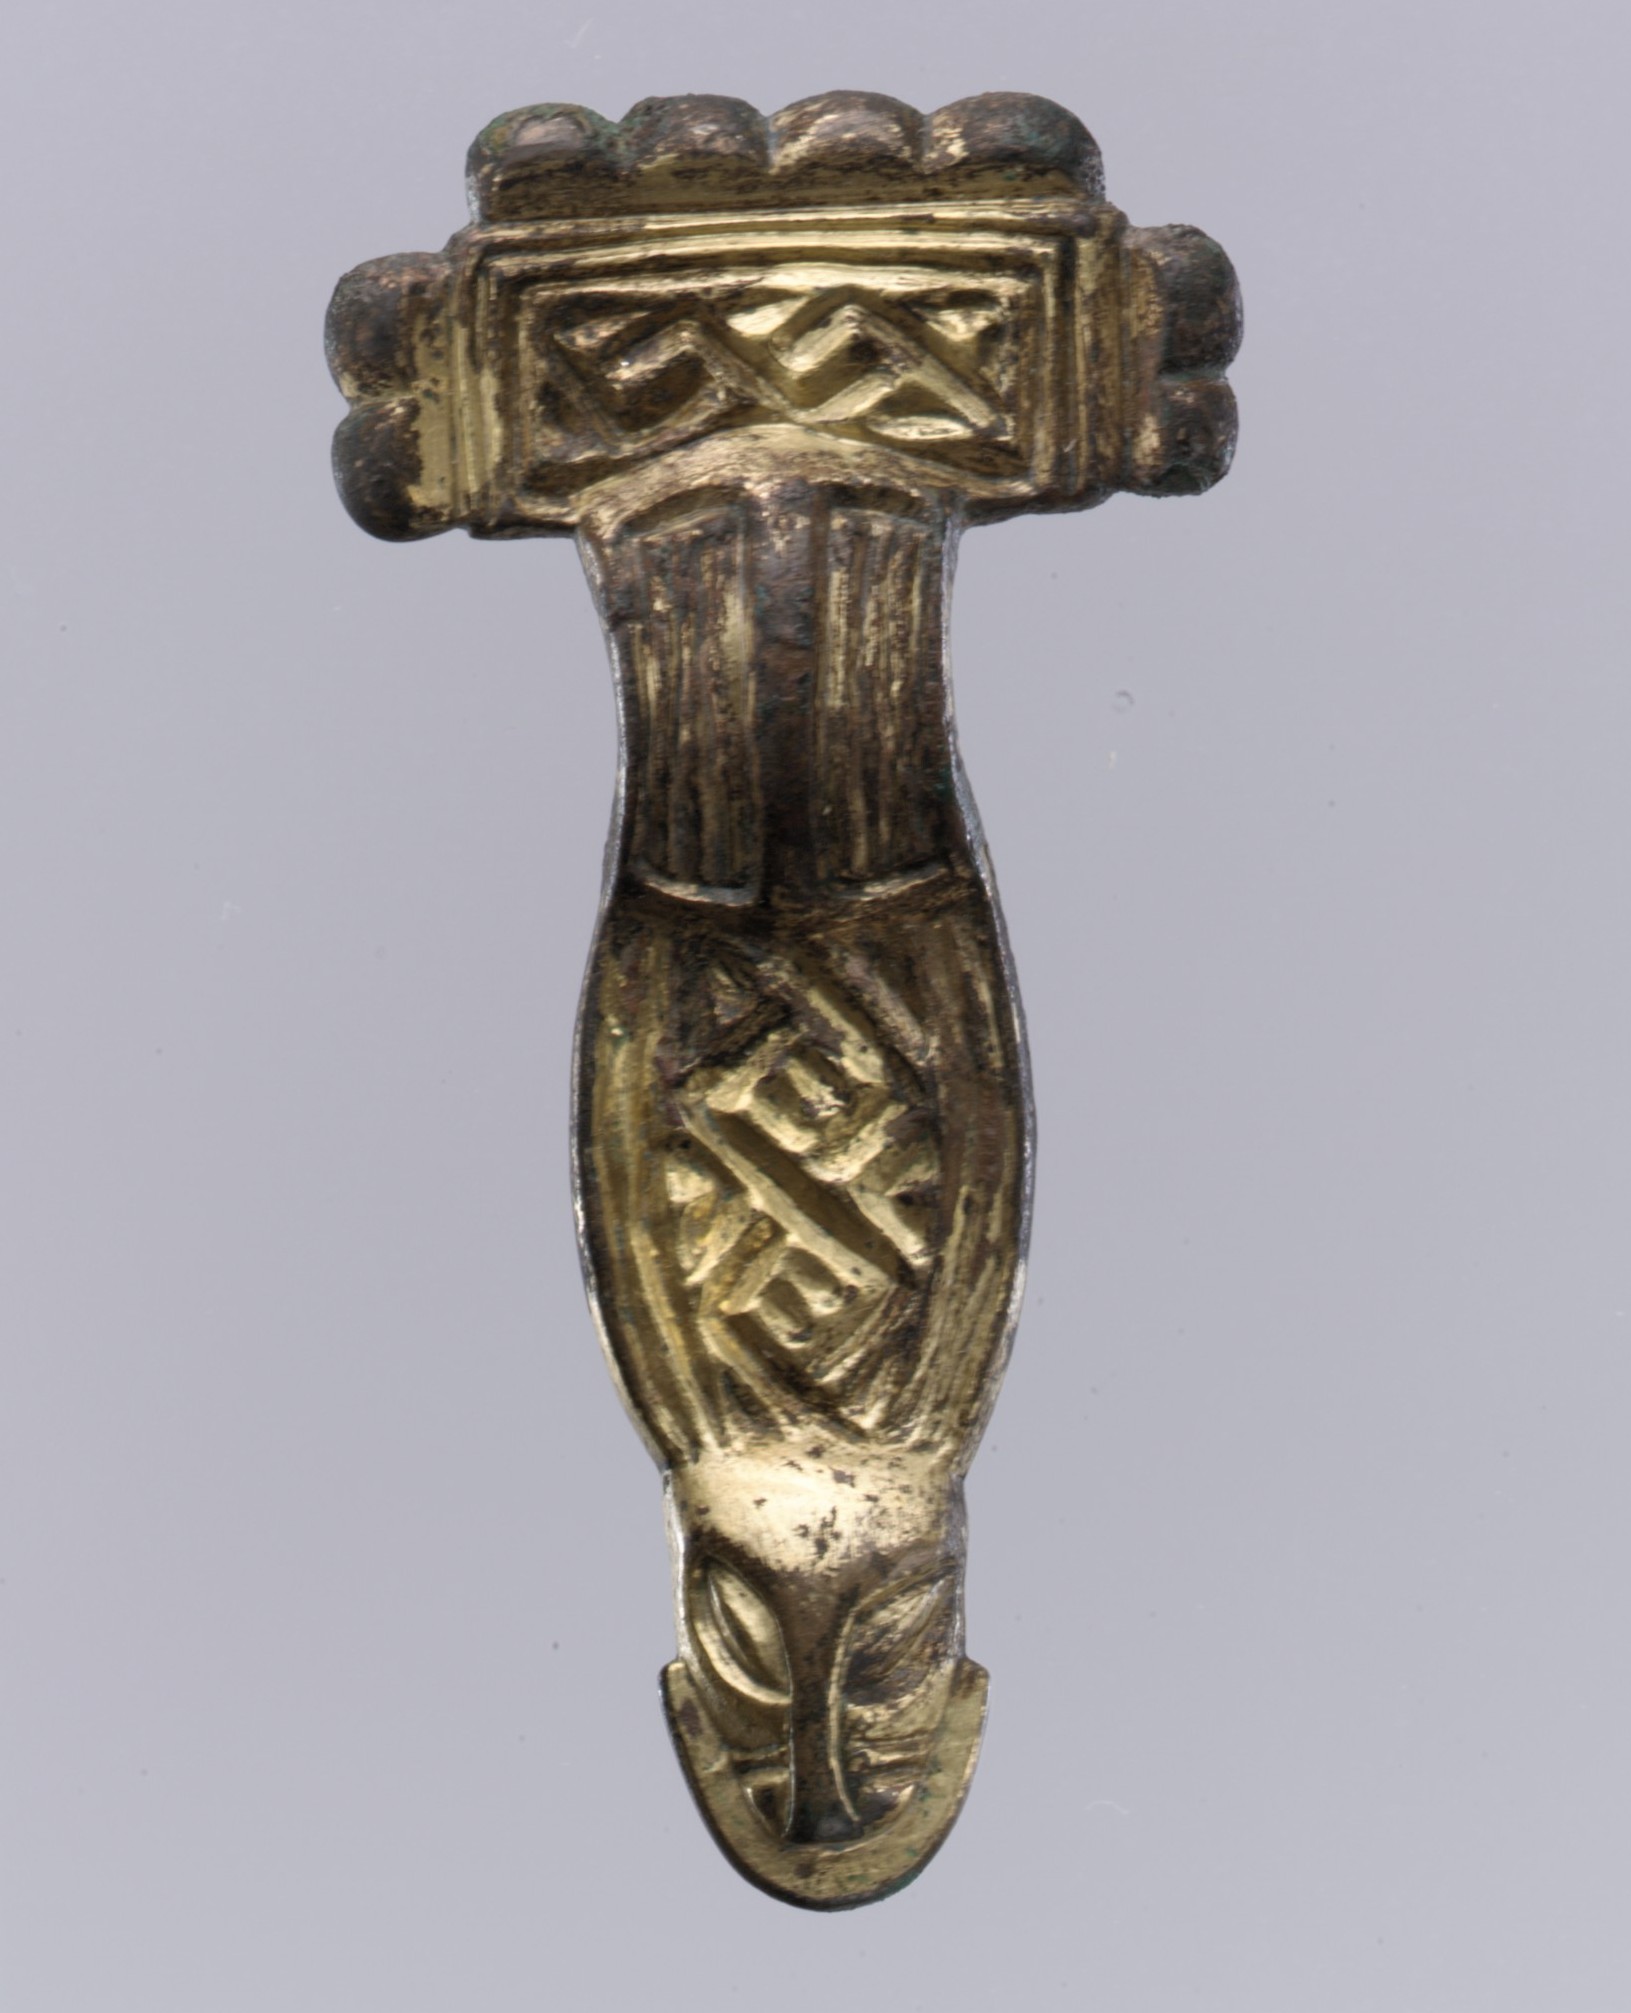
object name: brooch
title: Square-Headed Bow Brooch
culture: langobardic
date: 501-550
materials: copper alloy, gilt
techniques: silvered